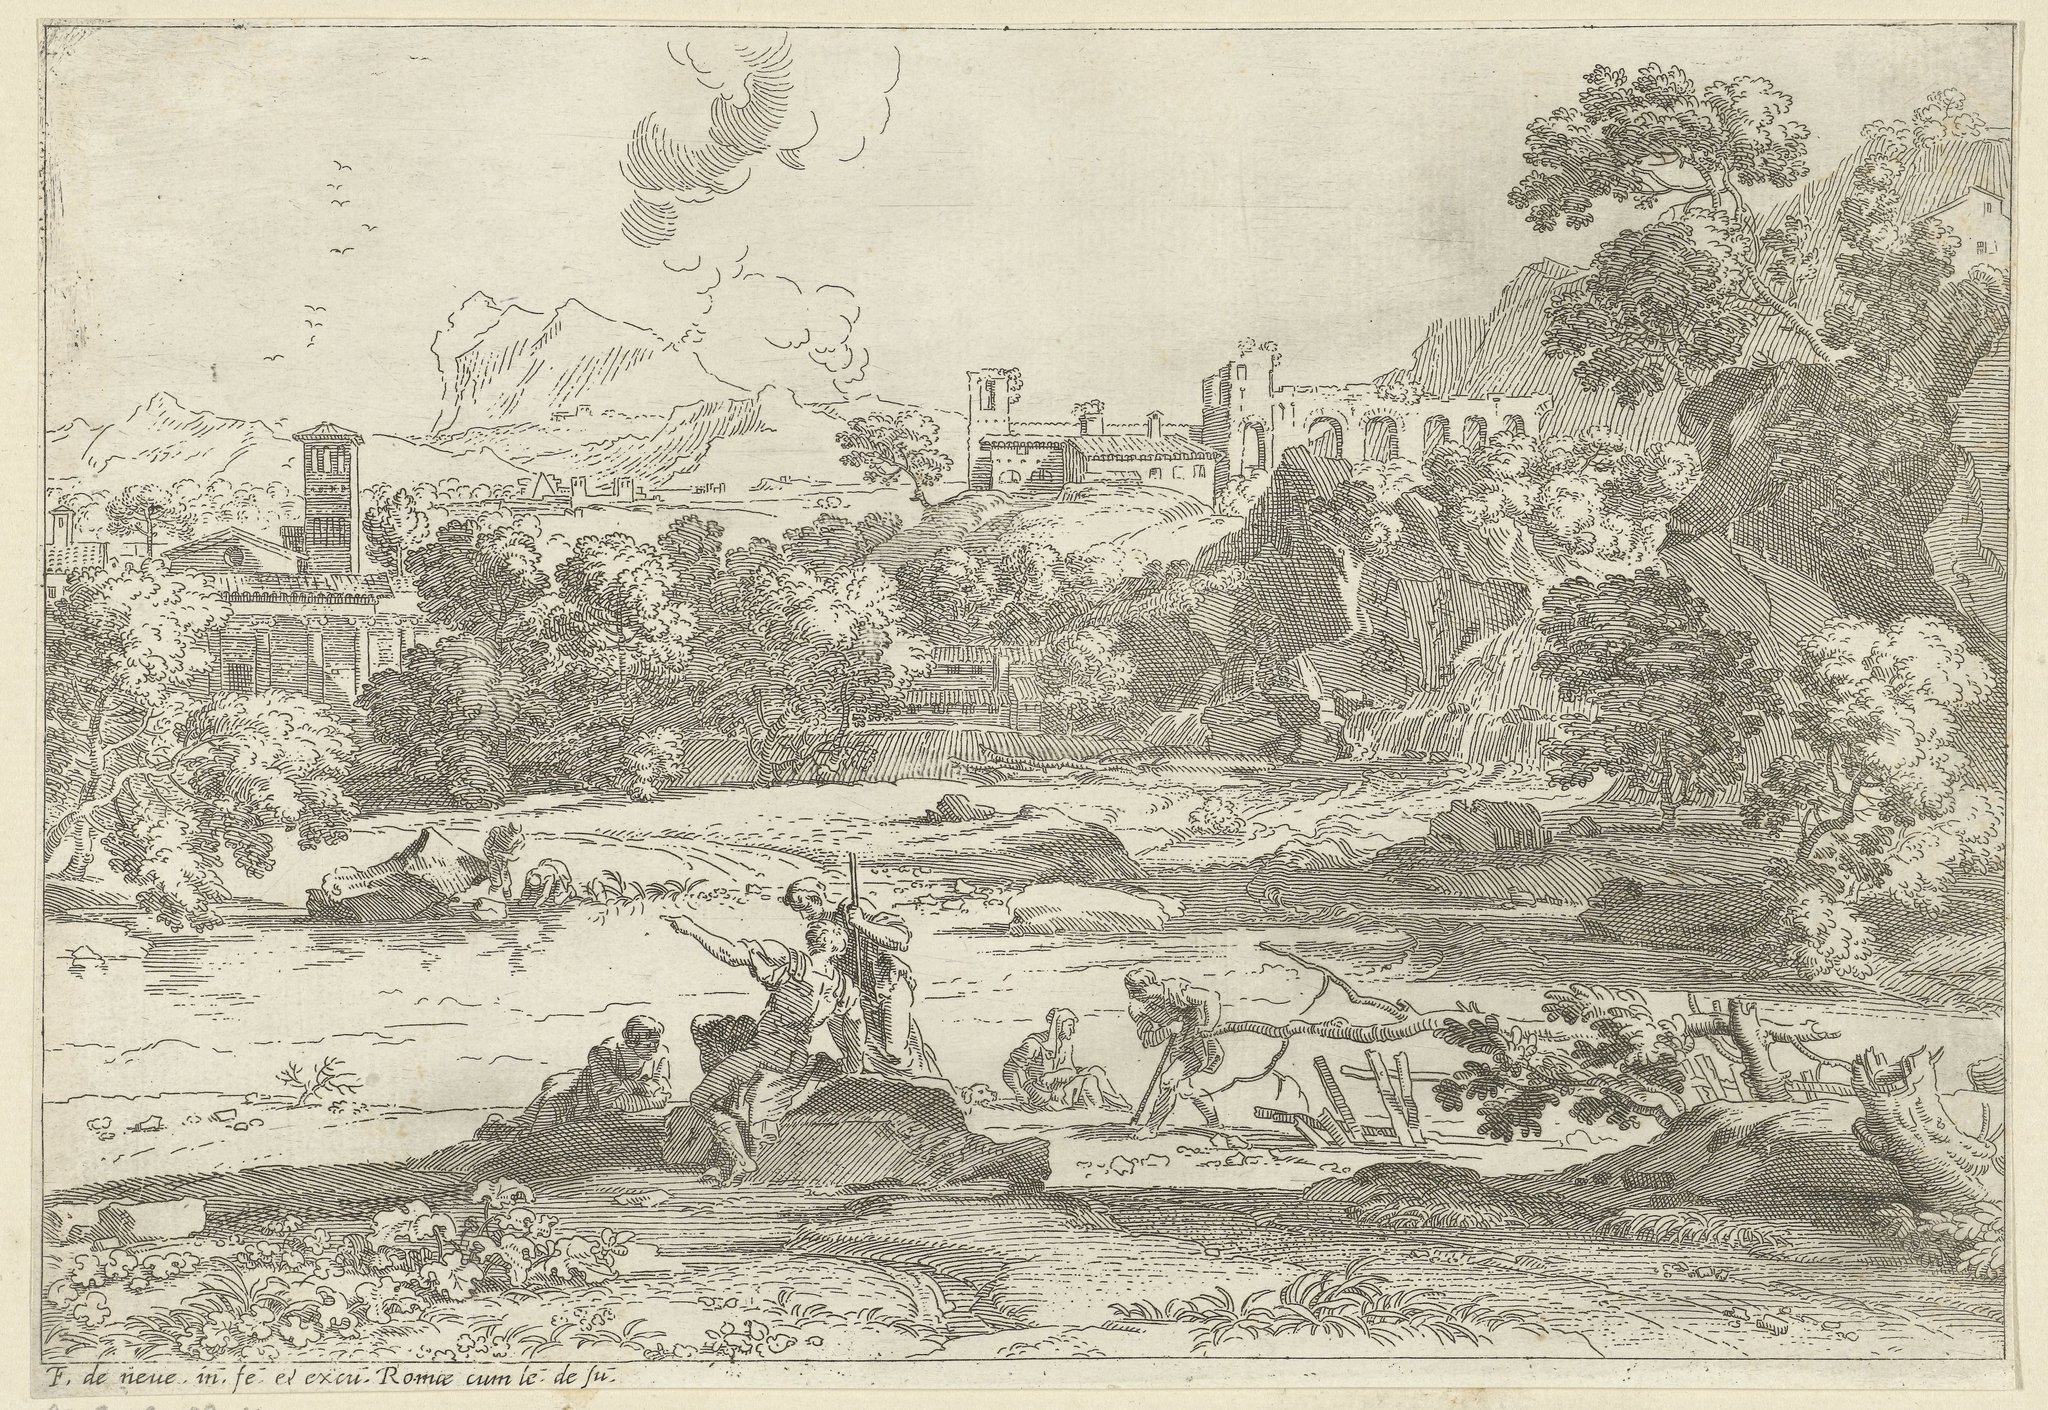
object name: print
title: Landschap met vijf figuren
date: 1616-1708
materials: paper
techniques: etching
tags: landscape with ruins, index finger forwards, pointing, indicating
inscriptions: collector's mark: Lugt 240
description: In een landschap met ruïnes rusten vijf figuren aan de oever van een rivier.